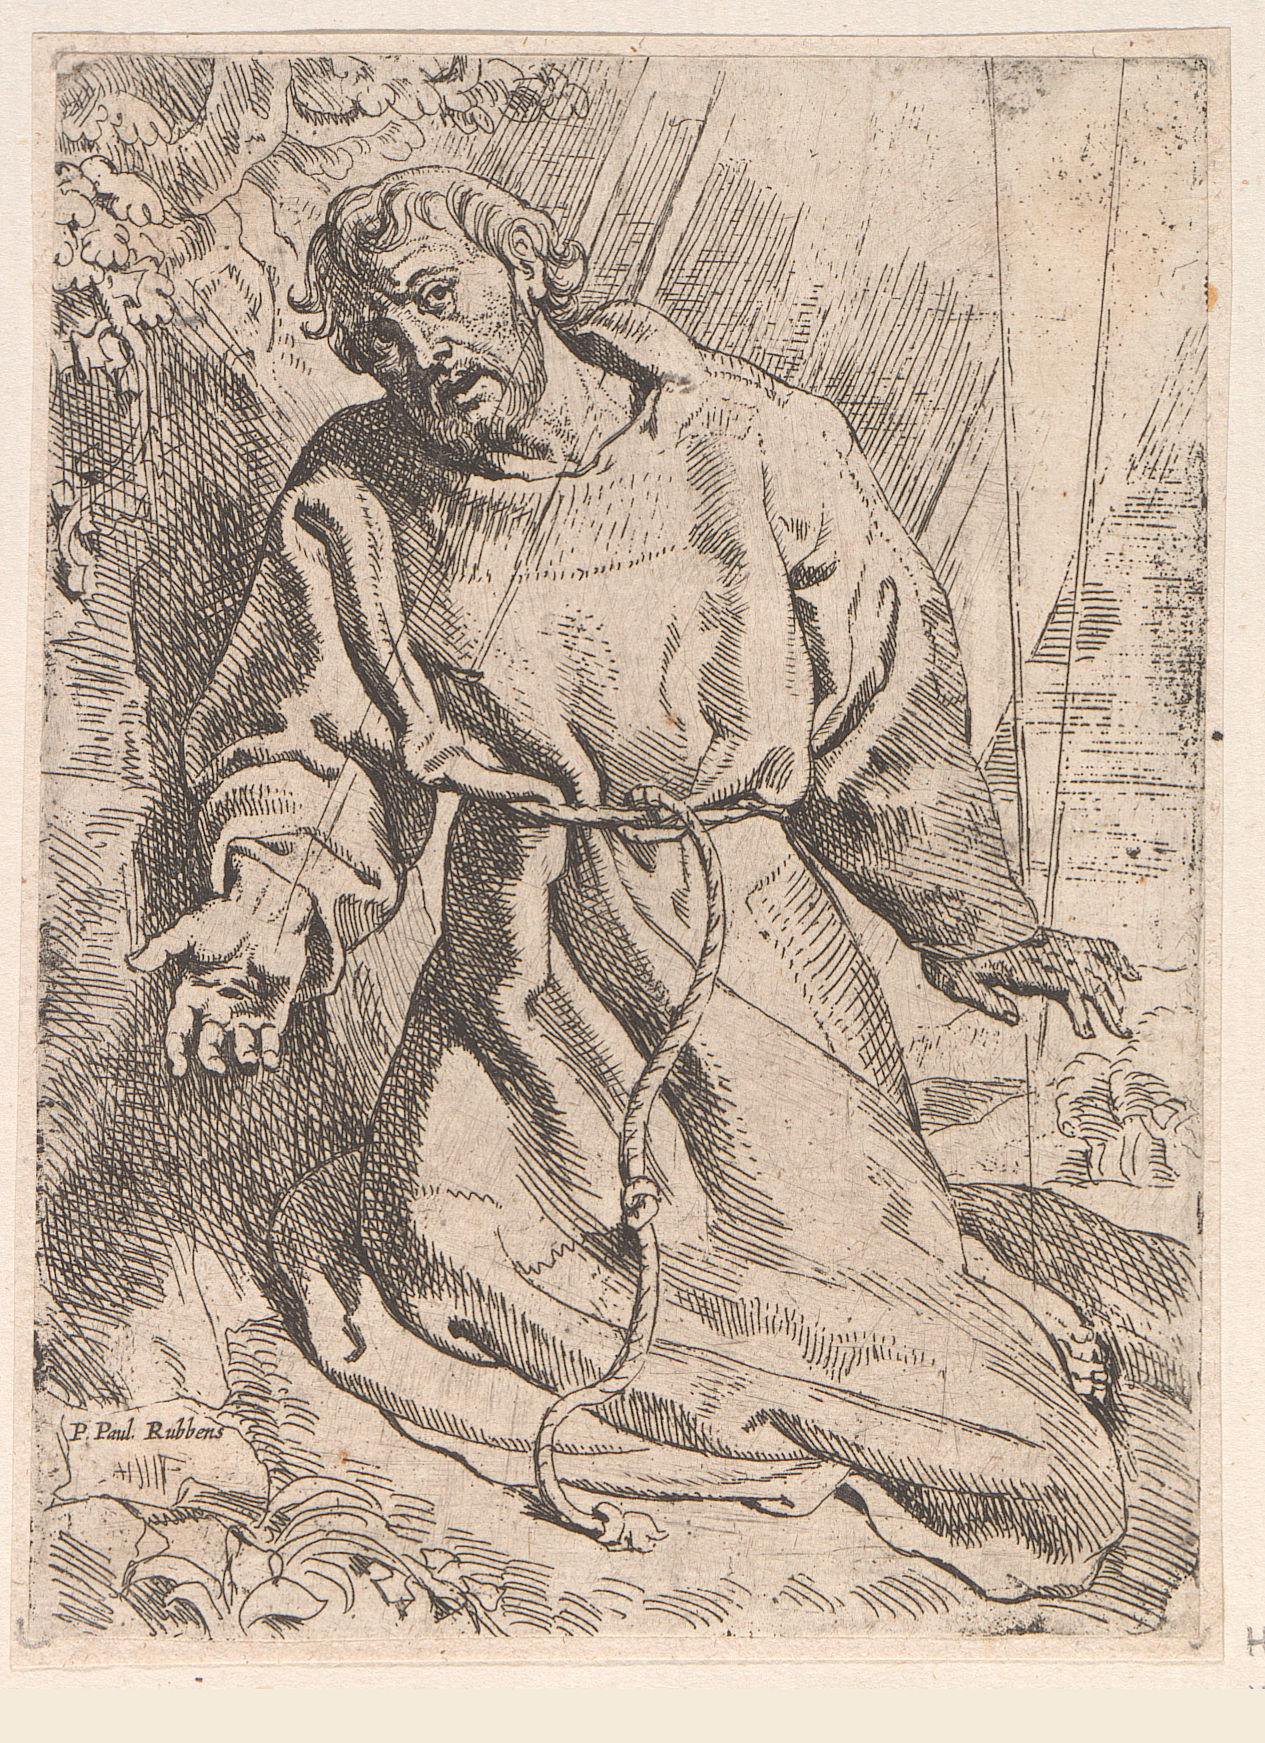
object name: print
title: H. Franciscus ontvangt de stigmata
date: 1613-1614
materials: paper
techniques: etching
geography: northern netherlands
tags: stigmatization of st. francis of assisi: in retreat on mount alverna, he beholds a vision of christ on the cross enveloped by wings (like a seraph with six wings); rays passing down to the body of the kneeling saint form the marks of the five wounds of christ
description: De heilige Franciscus van Assisi knielt op een berg, waar hij de stigmata ontvangt. Mogelijk een paar samen met de prent van Maria Magdalena. Deze prent maakt deel uit van een album.